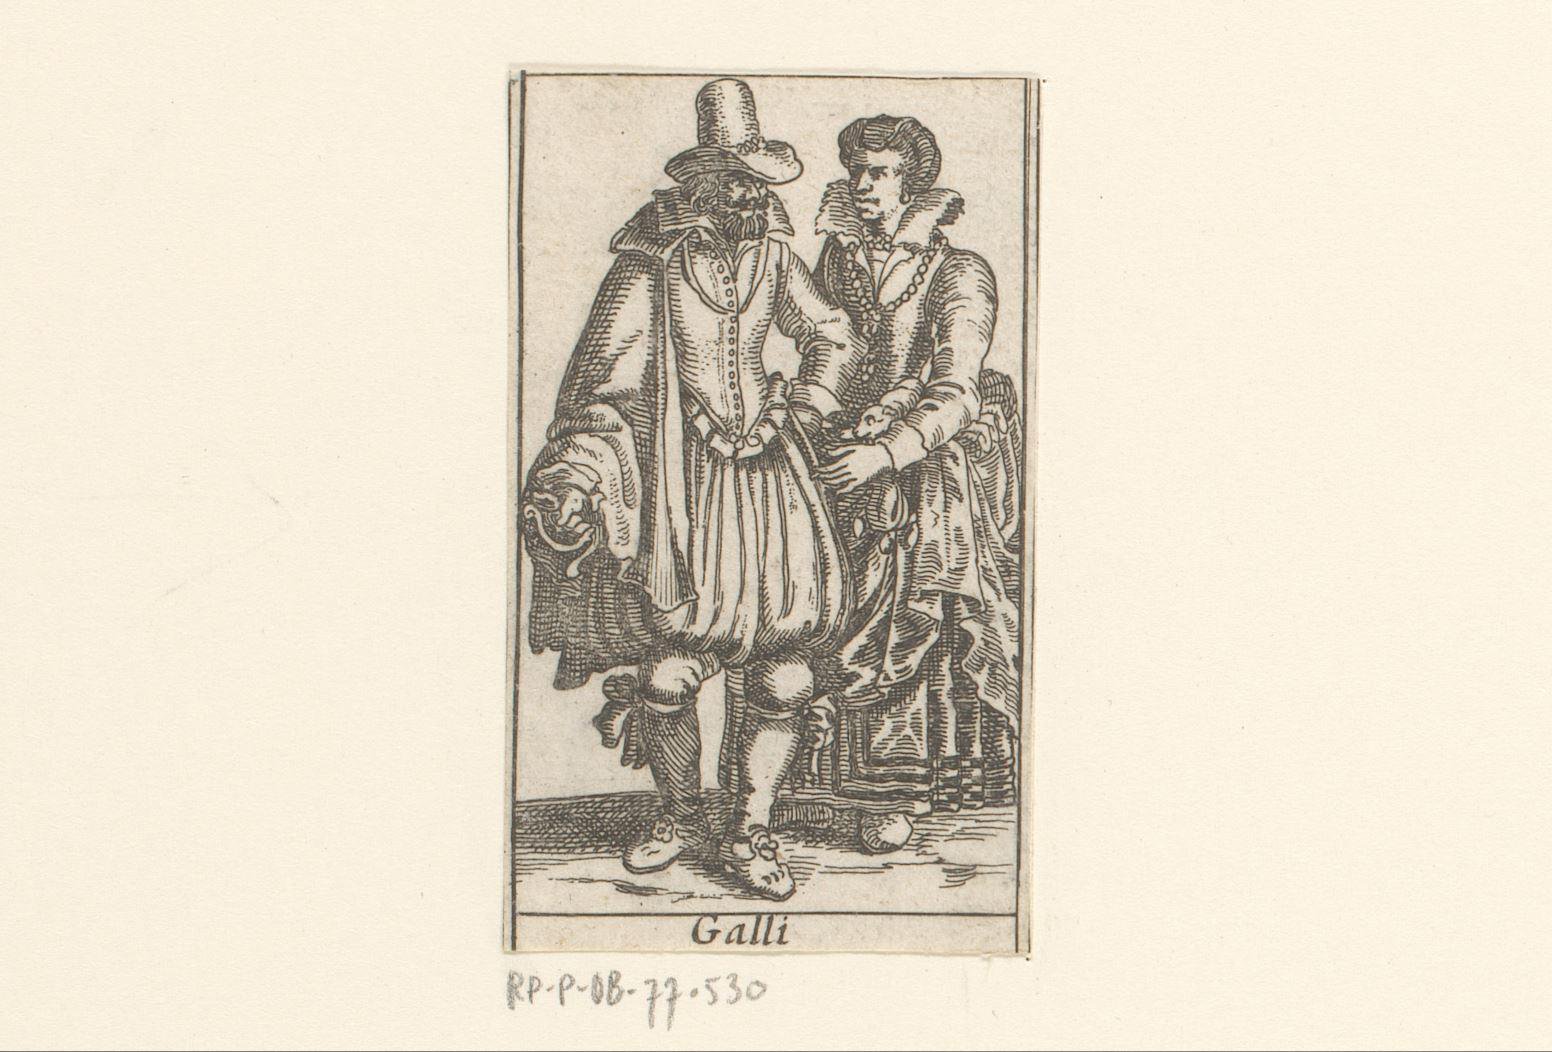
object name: print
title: Galli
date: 1617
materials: paper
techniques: etching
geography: amsterdam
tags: europeans (with name) (+ costume), clothes, costume, france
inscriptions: collector's mark: Lugt 2228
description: Prent is geknipt van de kaart van Europa van Willem Jansz. Blaeu uit 1617.